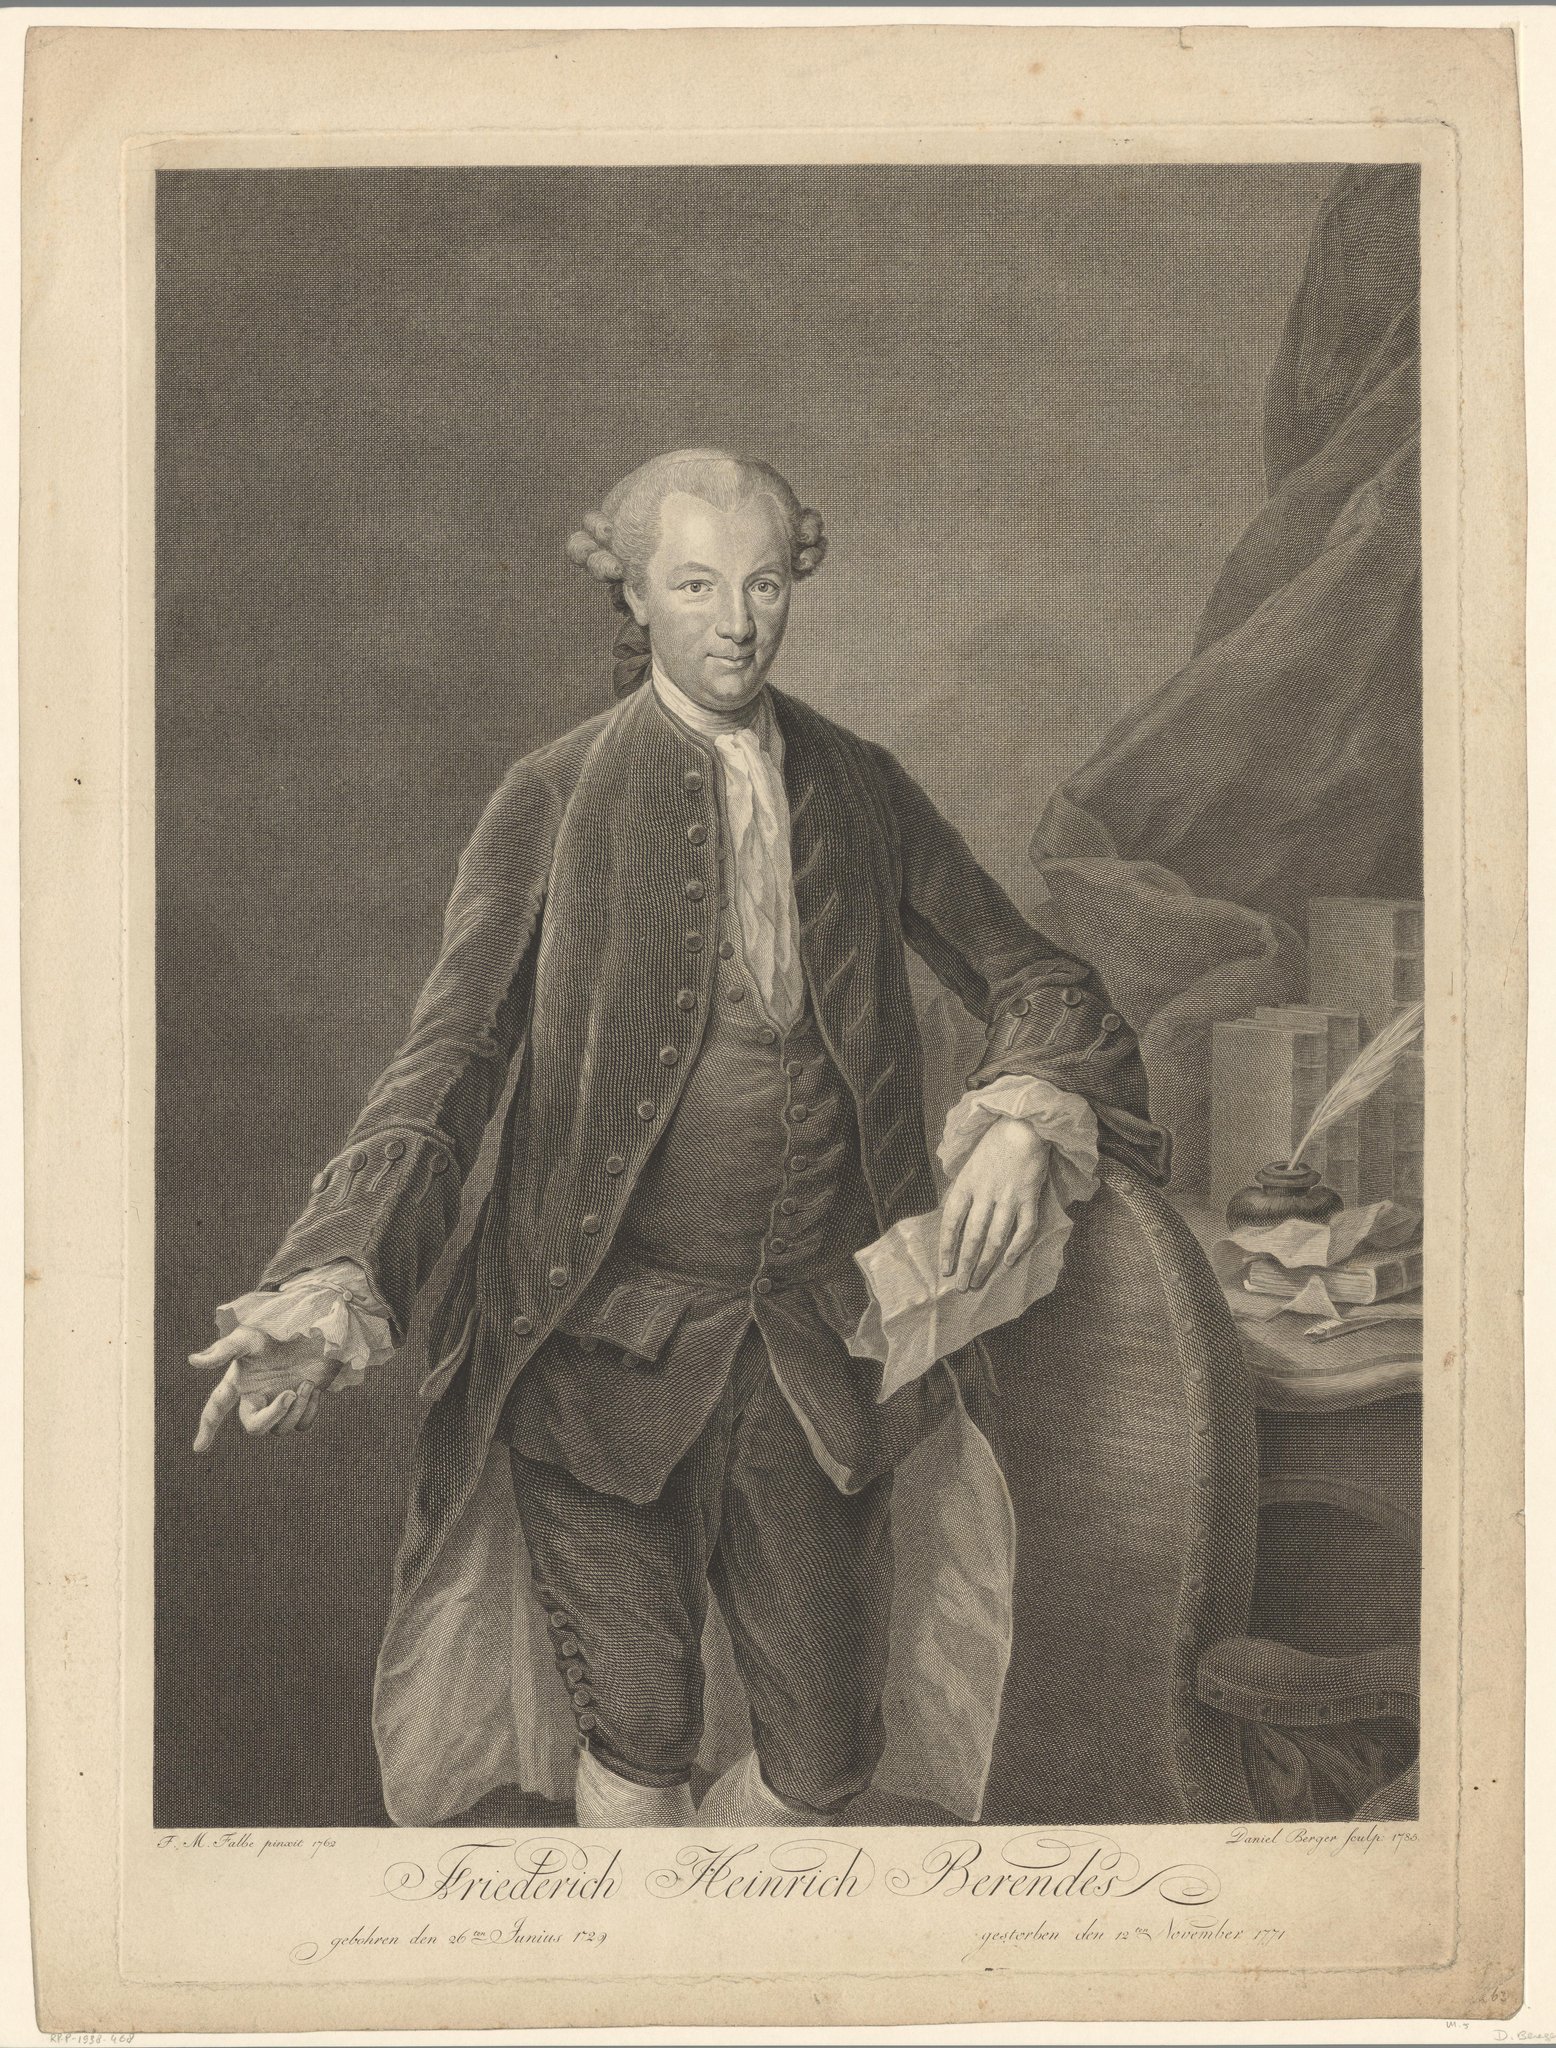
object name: print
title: Portret van Friedrich Heinrich Berendes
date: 1785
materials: paper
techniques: engraving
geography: berlin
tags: ink-well, historical persons, book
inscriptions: collector's mark: Lugt 2228